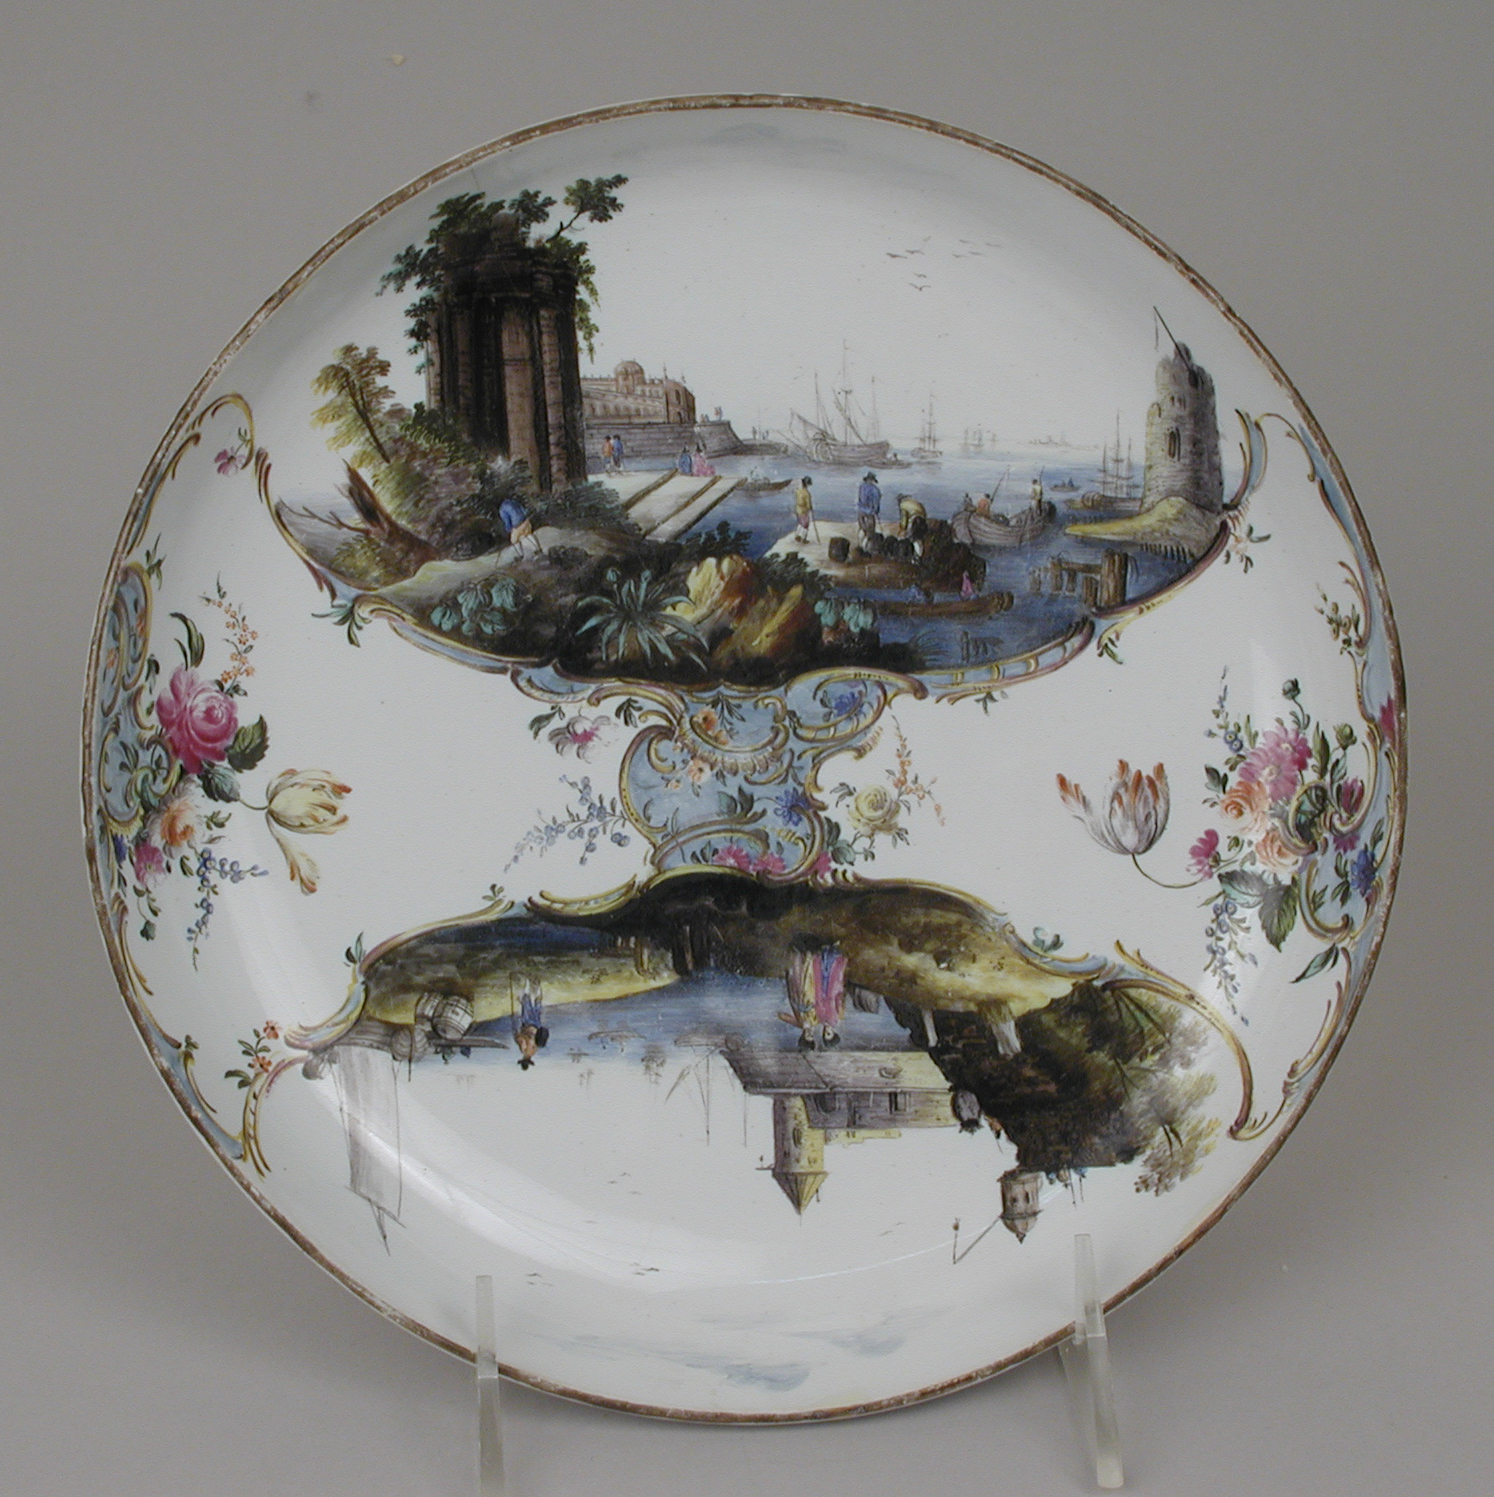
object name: dish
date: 1770-1780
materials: faience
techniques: glazing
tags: boats